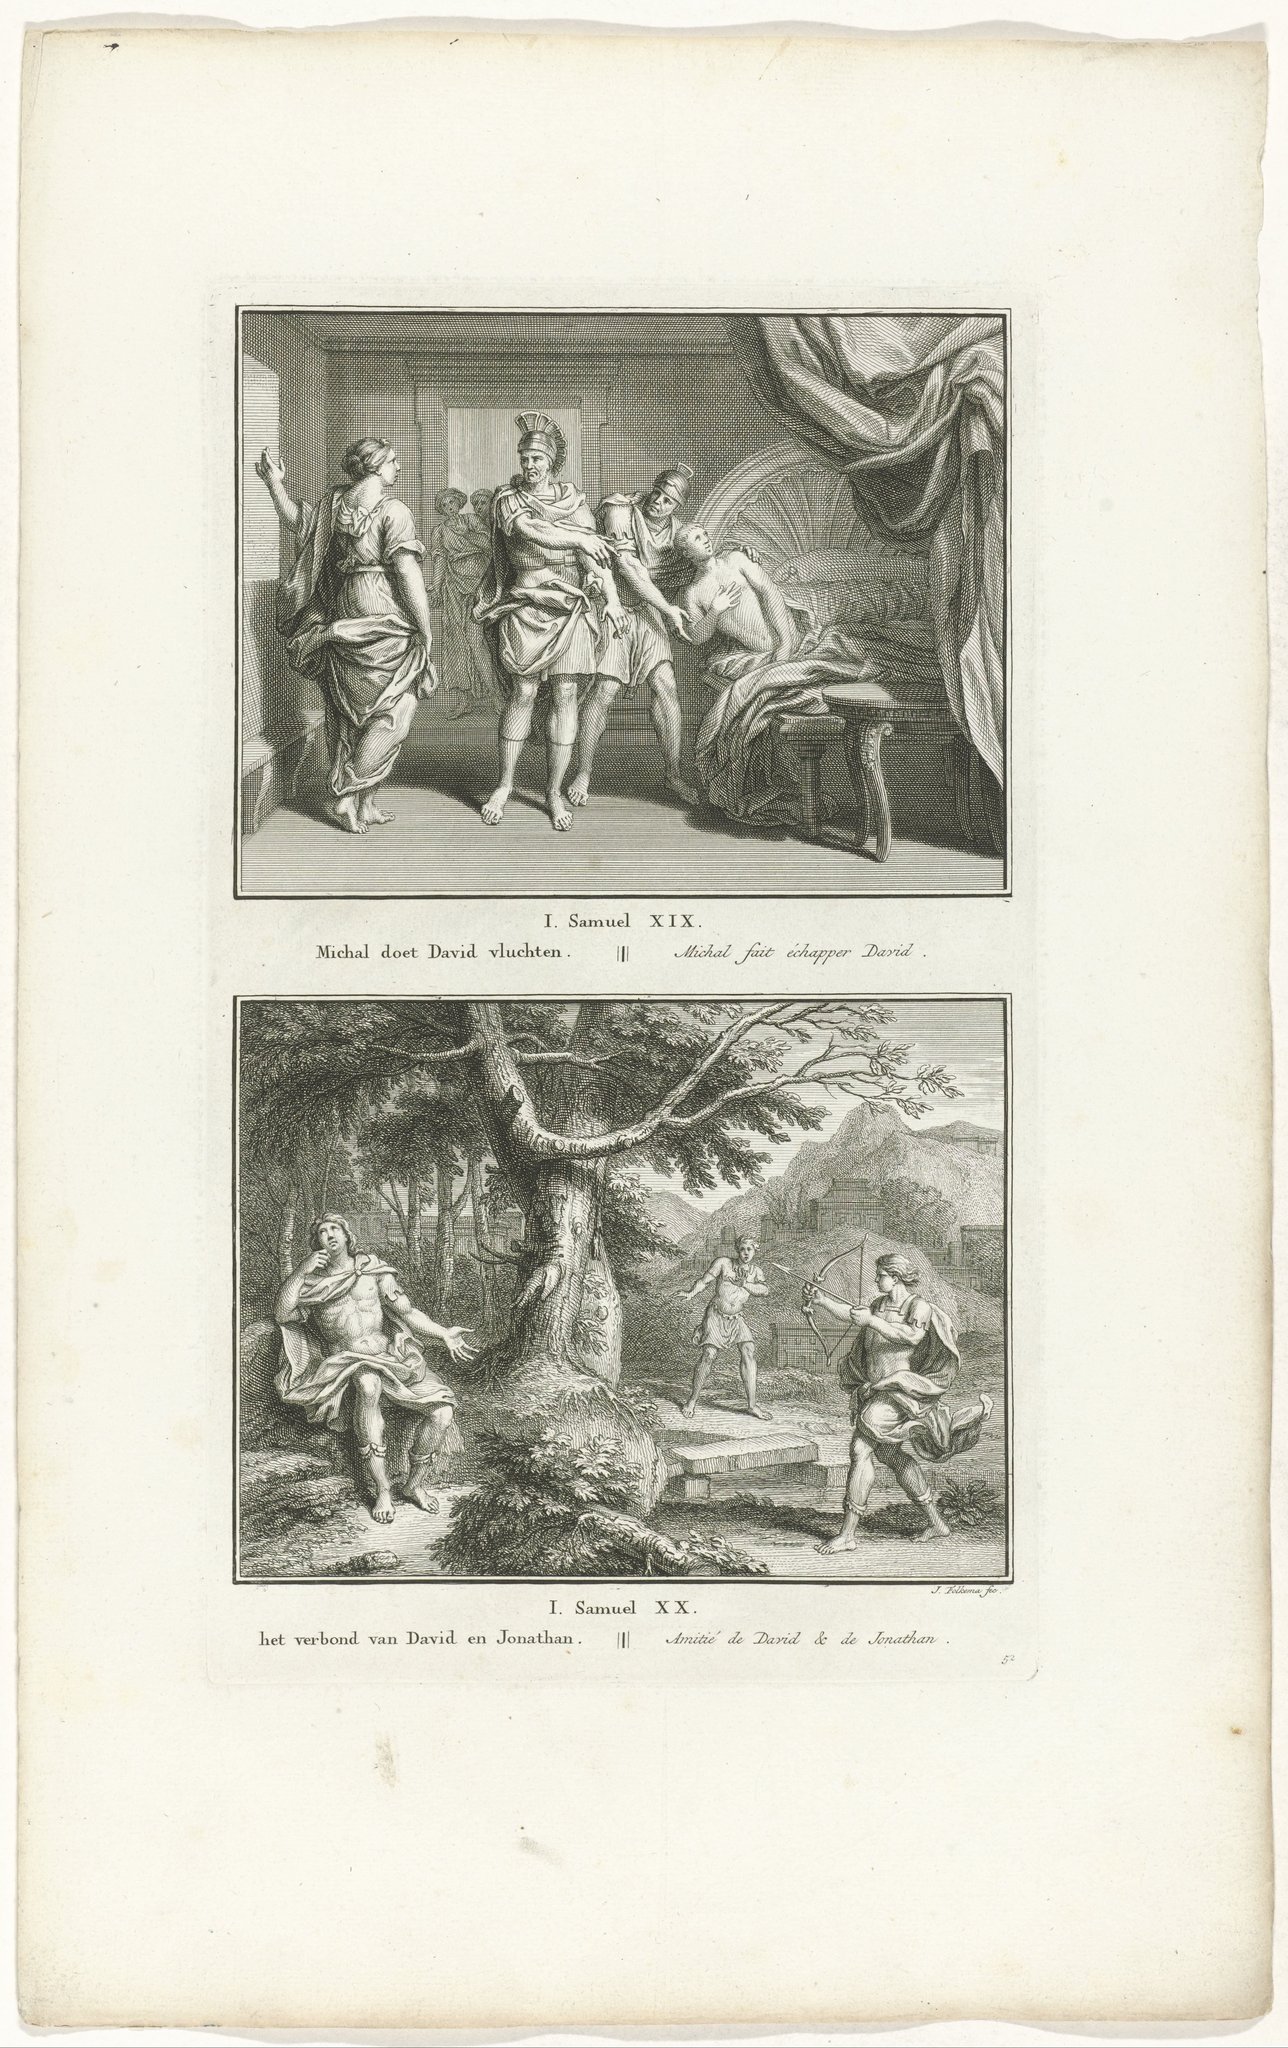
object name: print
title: Michal spoort David aan te vluchten en het verbond van David en Jonathan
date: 1791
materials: paper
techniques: etching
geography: dordrecht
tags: david consulting jonathan (in the field); jonathan pledges his loyalty, michal urging david to flee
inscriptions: collector's mark: Lugt 2233, collector's mark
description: Illustratie uit: Hamelsveld, Ysbrand van. De gewigtigste geschiedenissen des Bybels, afgebeeld in twee honderd twee en vijftig printverbeeldingen (...) met eene zaaklijke uitbreiding opgehelderd. Amsterdam / Dordrecht: Jan de Groot / Abraham en Pieter Blussé.